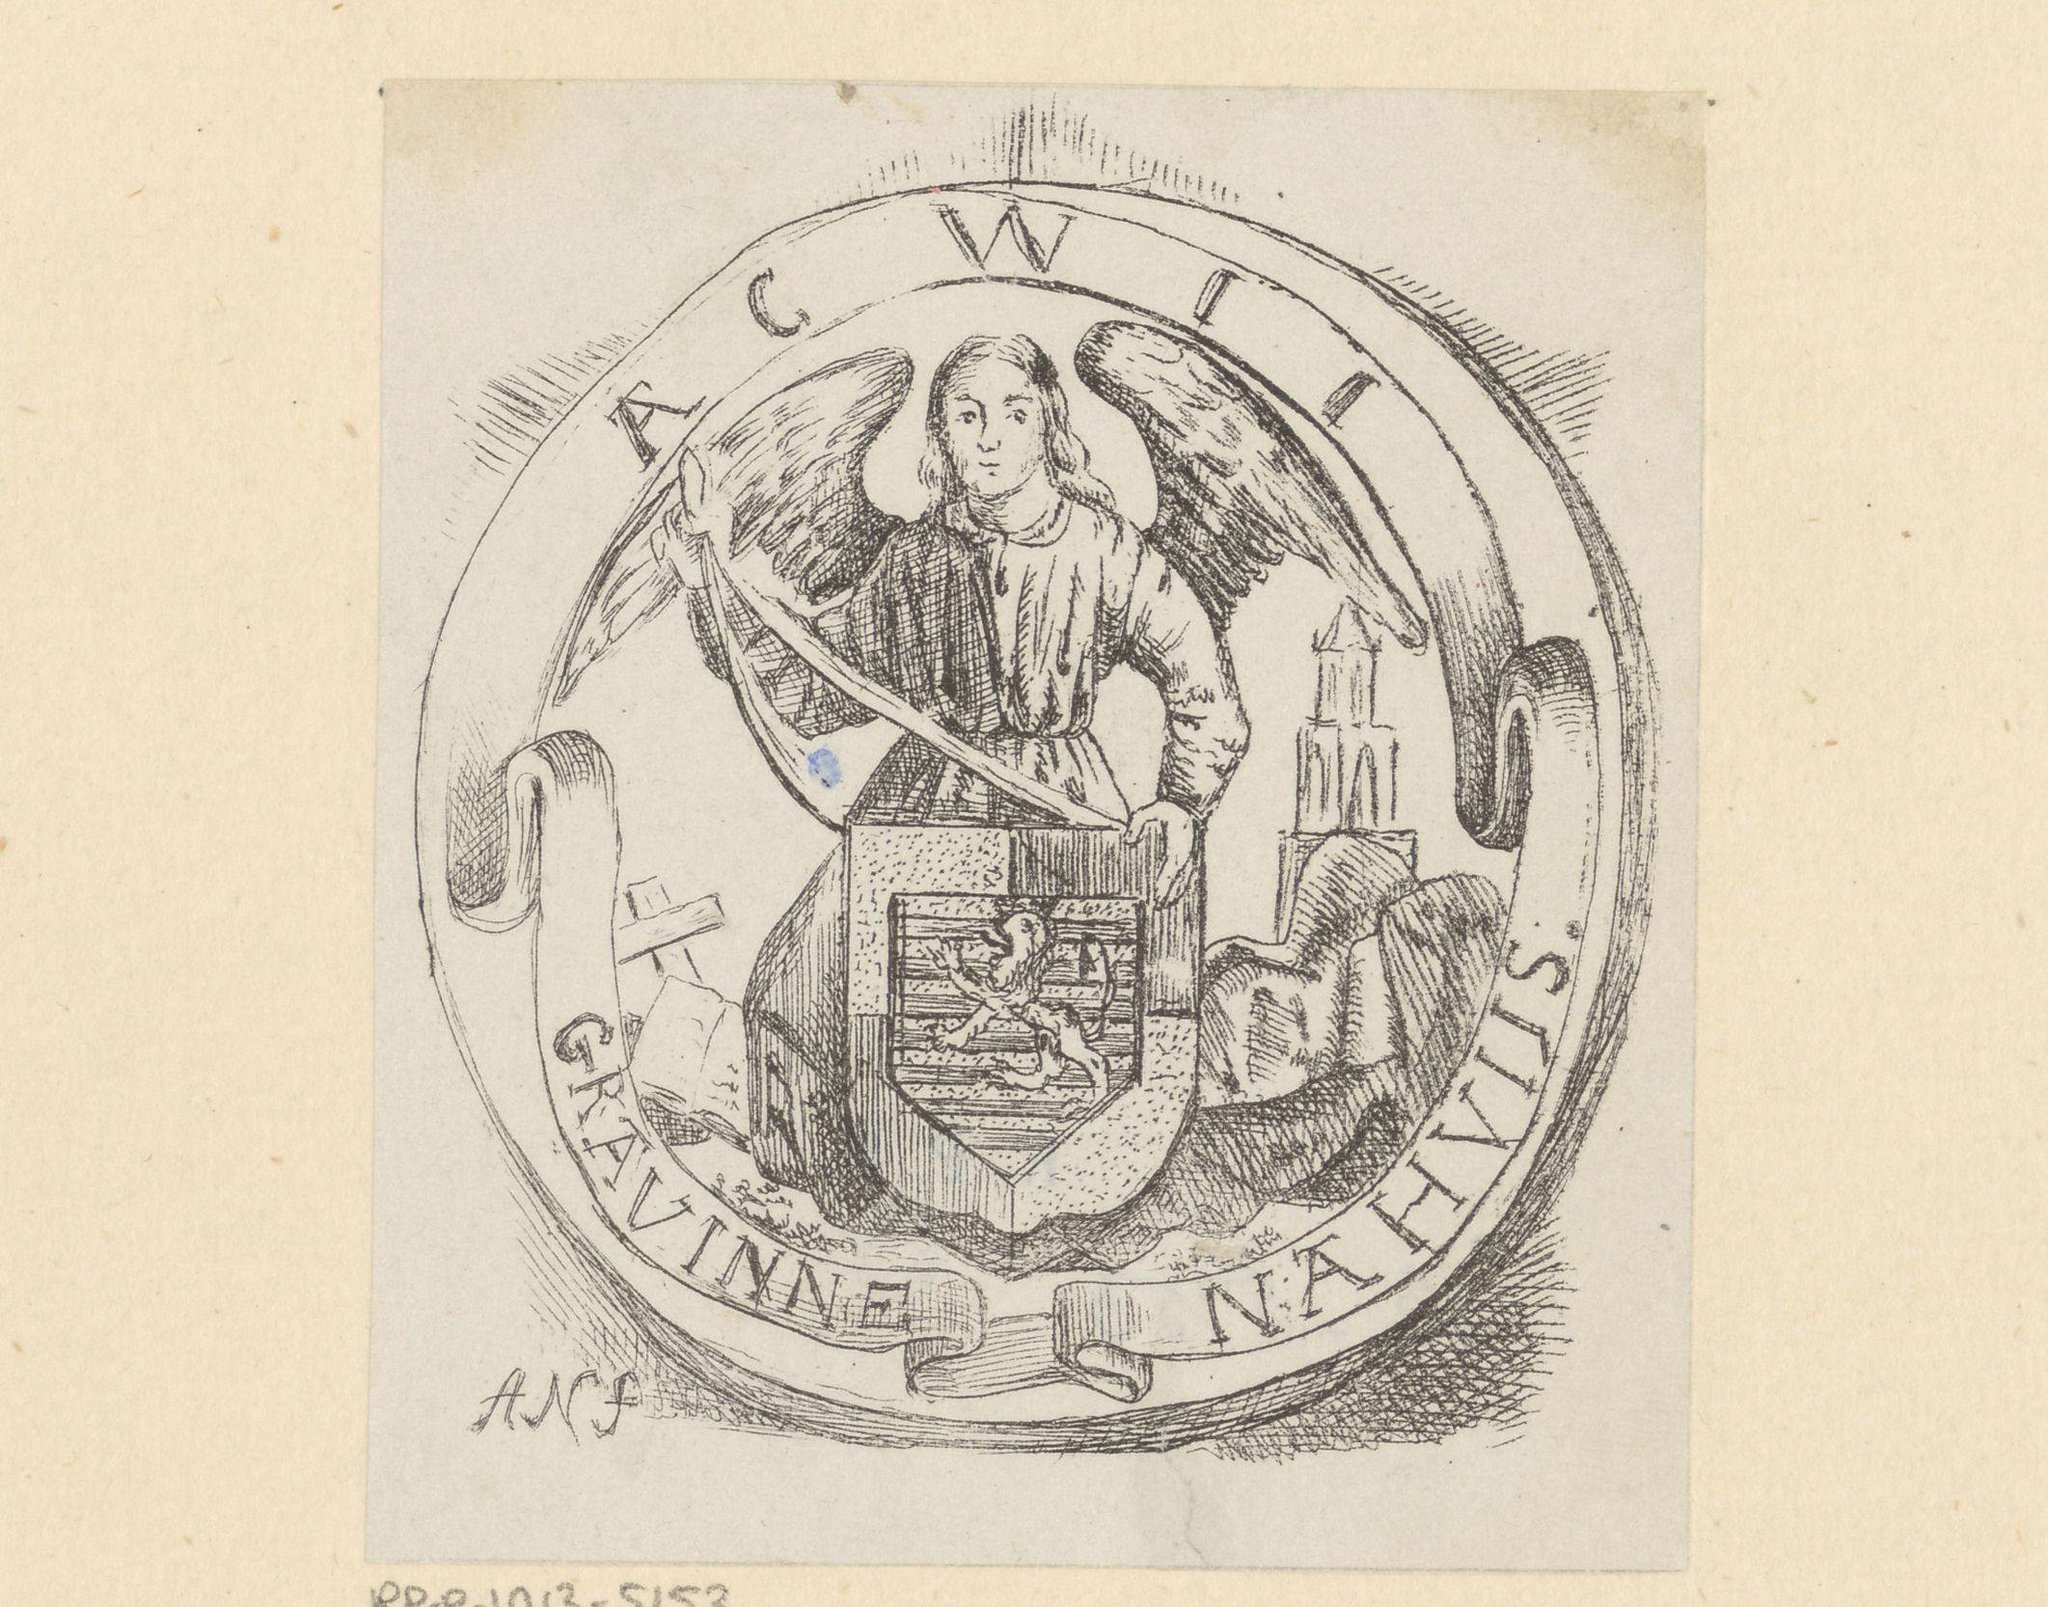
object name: bookplate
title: Ex libris van A.C.W.J.J. Nahuijs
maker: anna cécile wilhelmina jeanette jacqueline nahuys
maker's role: print maker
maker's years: 1826-1905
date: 1836-1905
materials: paper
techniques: printing block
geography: netherlands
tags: utrecht, amsterdam, anna cécile wilhelmina jeanette jacqueline nahuys, christian religion, angels, armorial bearing, heraldry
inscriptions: collector's mark: Lugt 2233, collector's mark: Lugt 2760